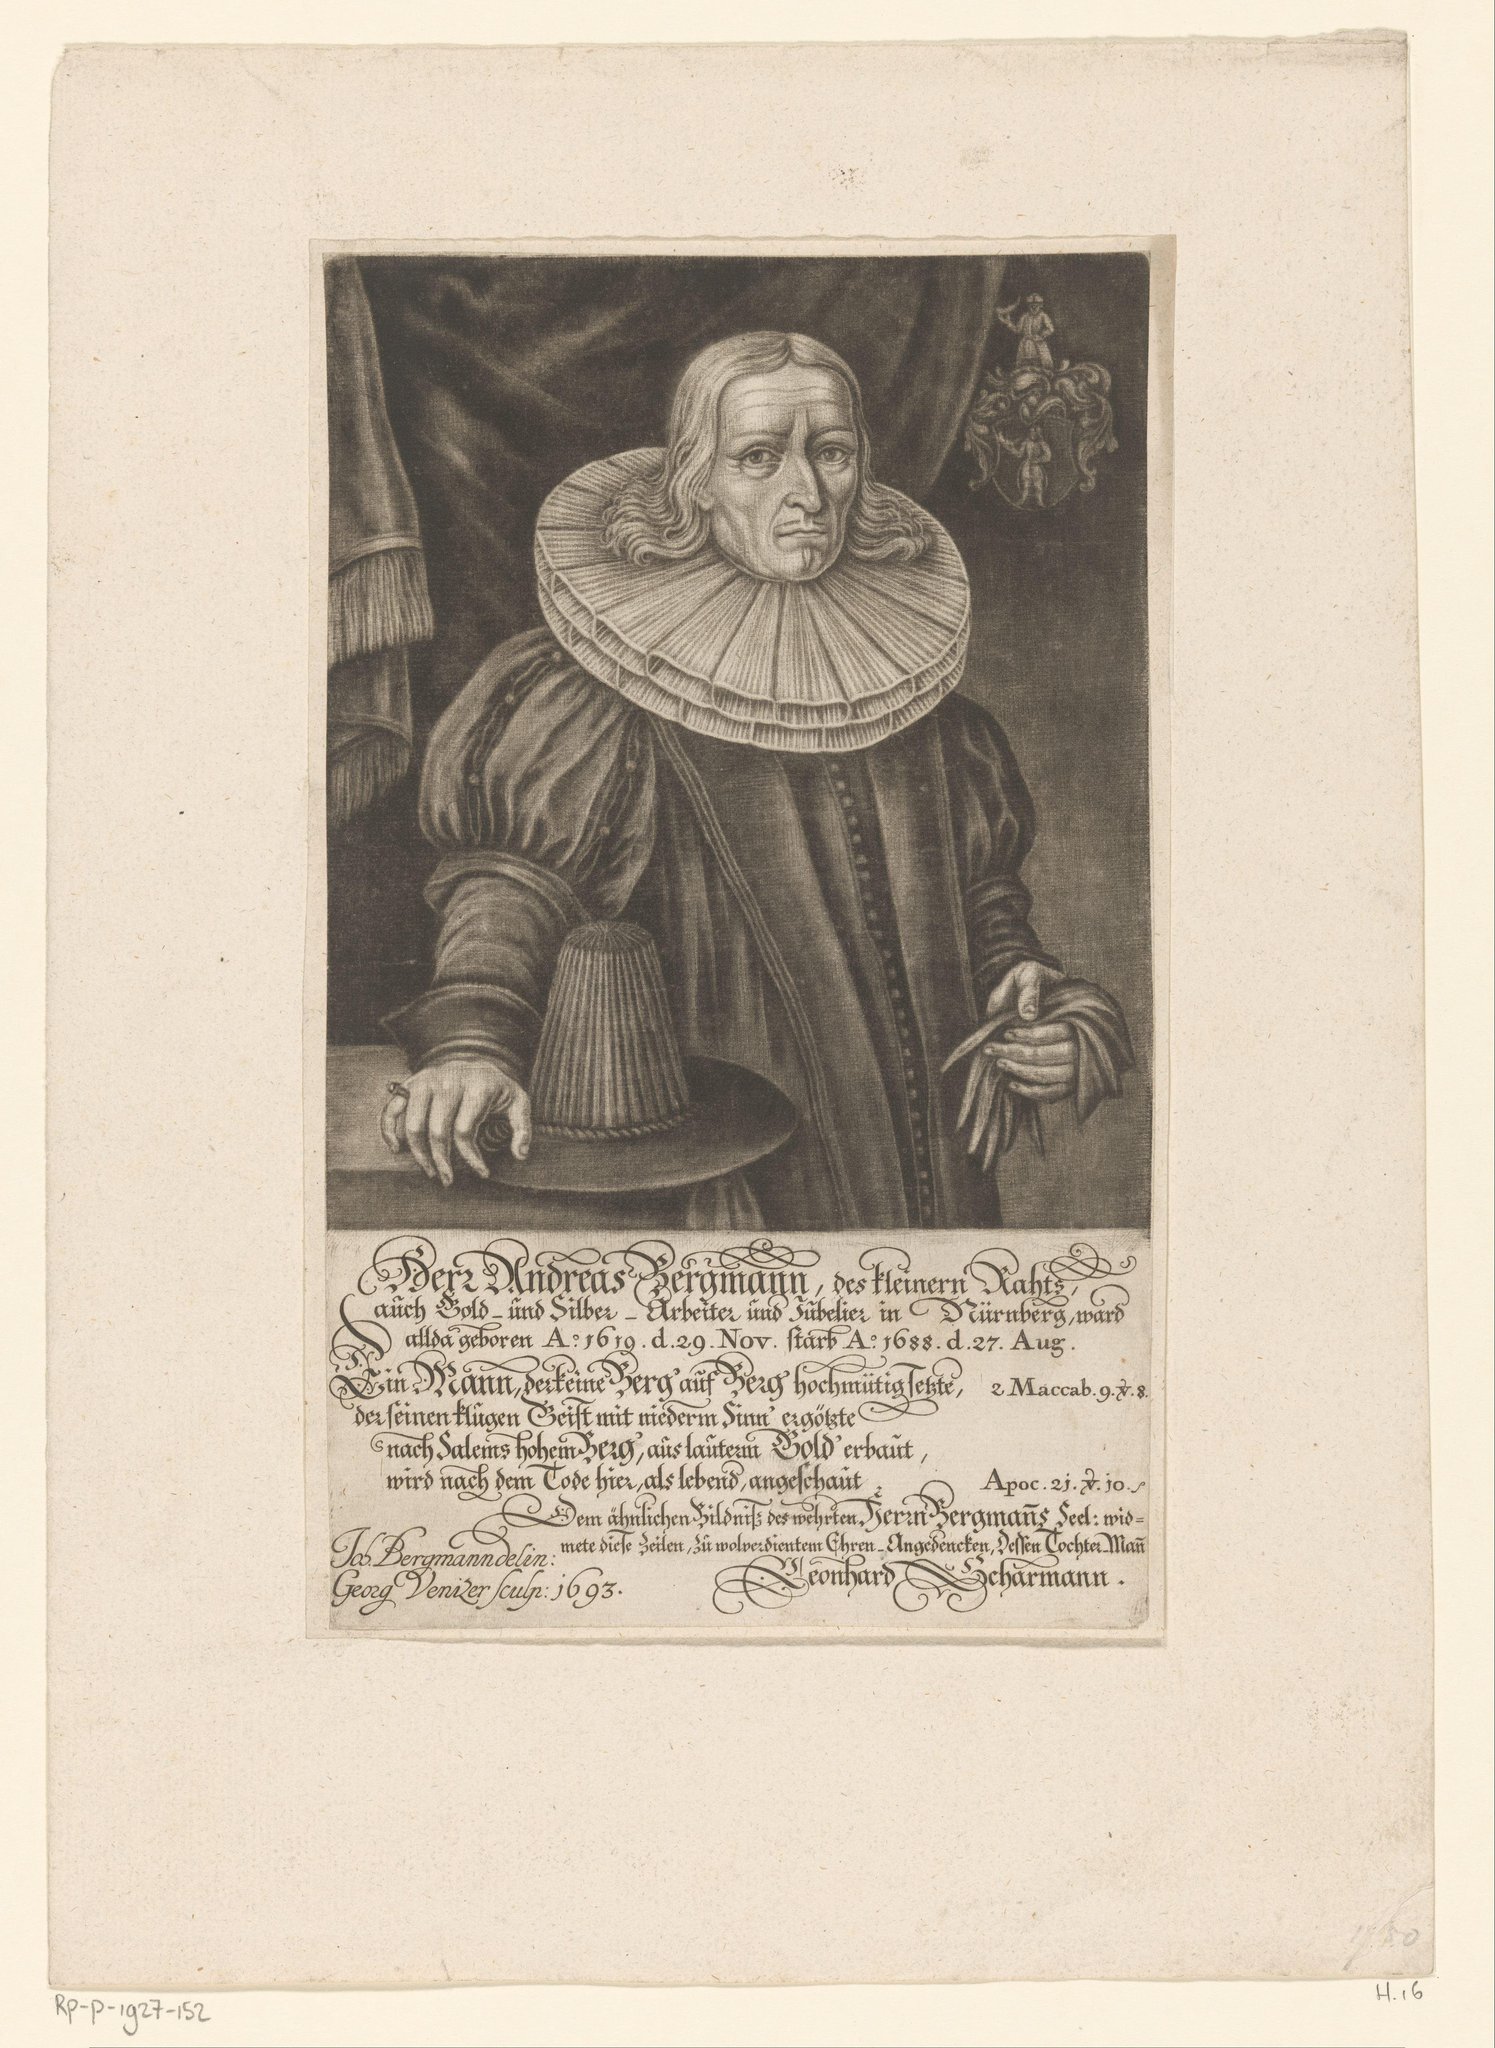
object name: print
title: Portret van Andreas Bergmann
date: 1693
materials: paper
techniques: mezzotint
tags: goldsmith, gloves, mittens, etc., historical persons, head-gear: hat, armorial bearing, heraldry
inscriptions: date